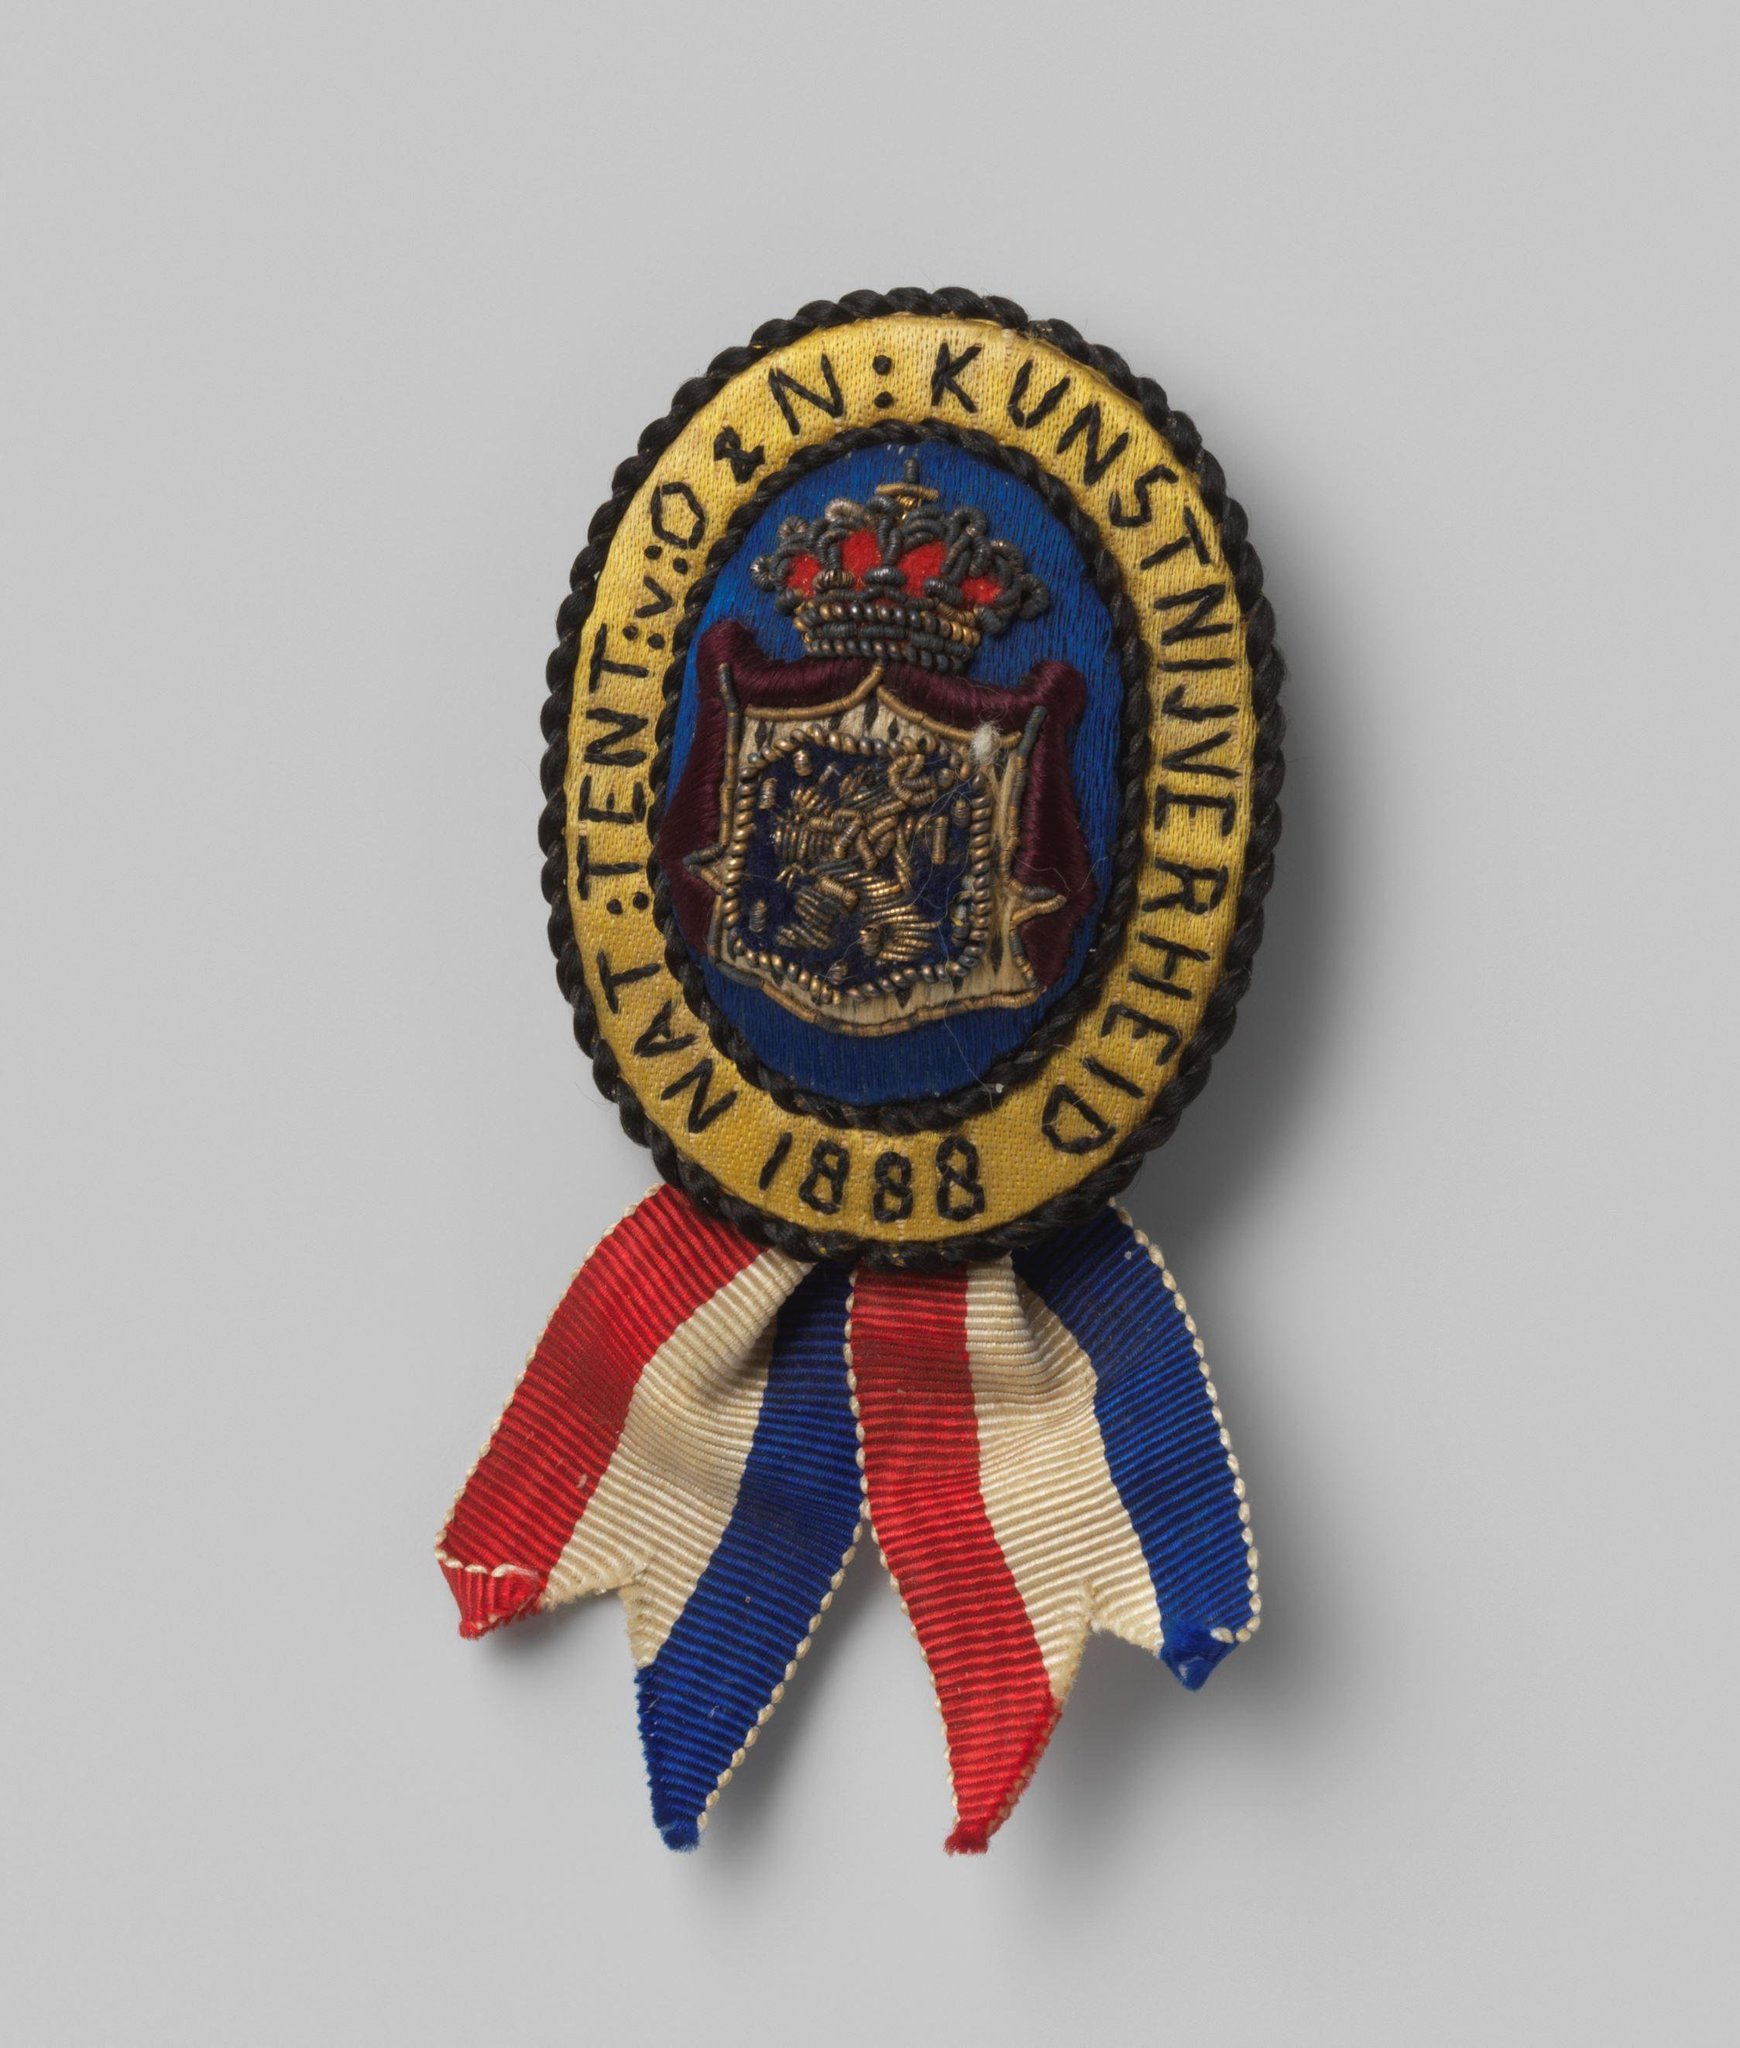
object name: insignia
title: Tentoonstelling kunstnijverheid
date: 1888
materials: cardboard, copper, gold thread, paper, silk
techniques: embroidered, forging, printing, stitching, weave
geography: the hague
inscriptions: date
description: Koperen ovaal draagteken waaraan twee rood-wit-blauwe vlaggetjes met gevorkte uiteinden hangen. De rand van het draagteken is zwart-geel-zwart met zwarte letters in de gele baan, het middengedeelte bestaat uit een blauw veld waarop het gekroonde wapen van Nederland in hermelijnmantel geborduurd is. Keerzijde: een veiligheidsspeld en etiket van de maker. Randschrift: NAT: TENT: v: O&N: KUNSTNIJVERHEID. Gesigneerd keerzijde op etiket: A. A. KNUIJVER / FABRIEKANT. Gedateerd midden onder: 1888.